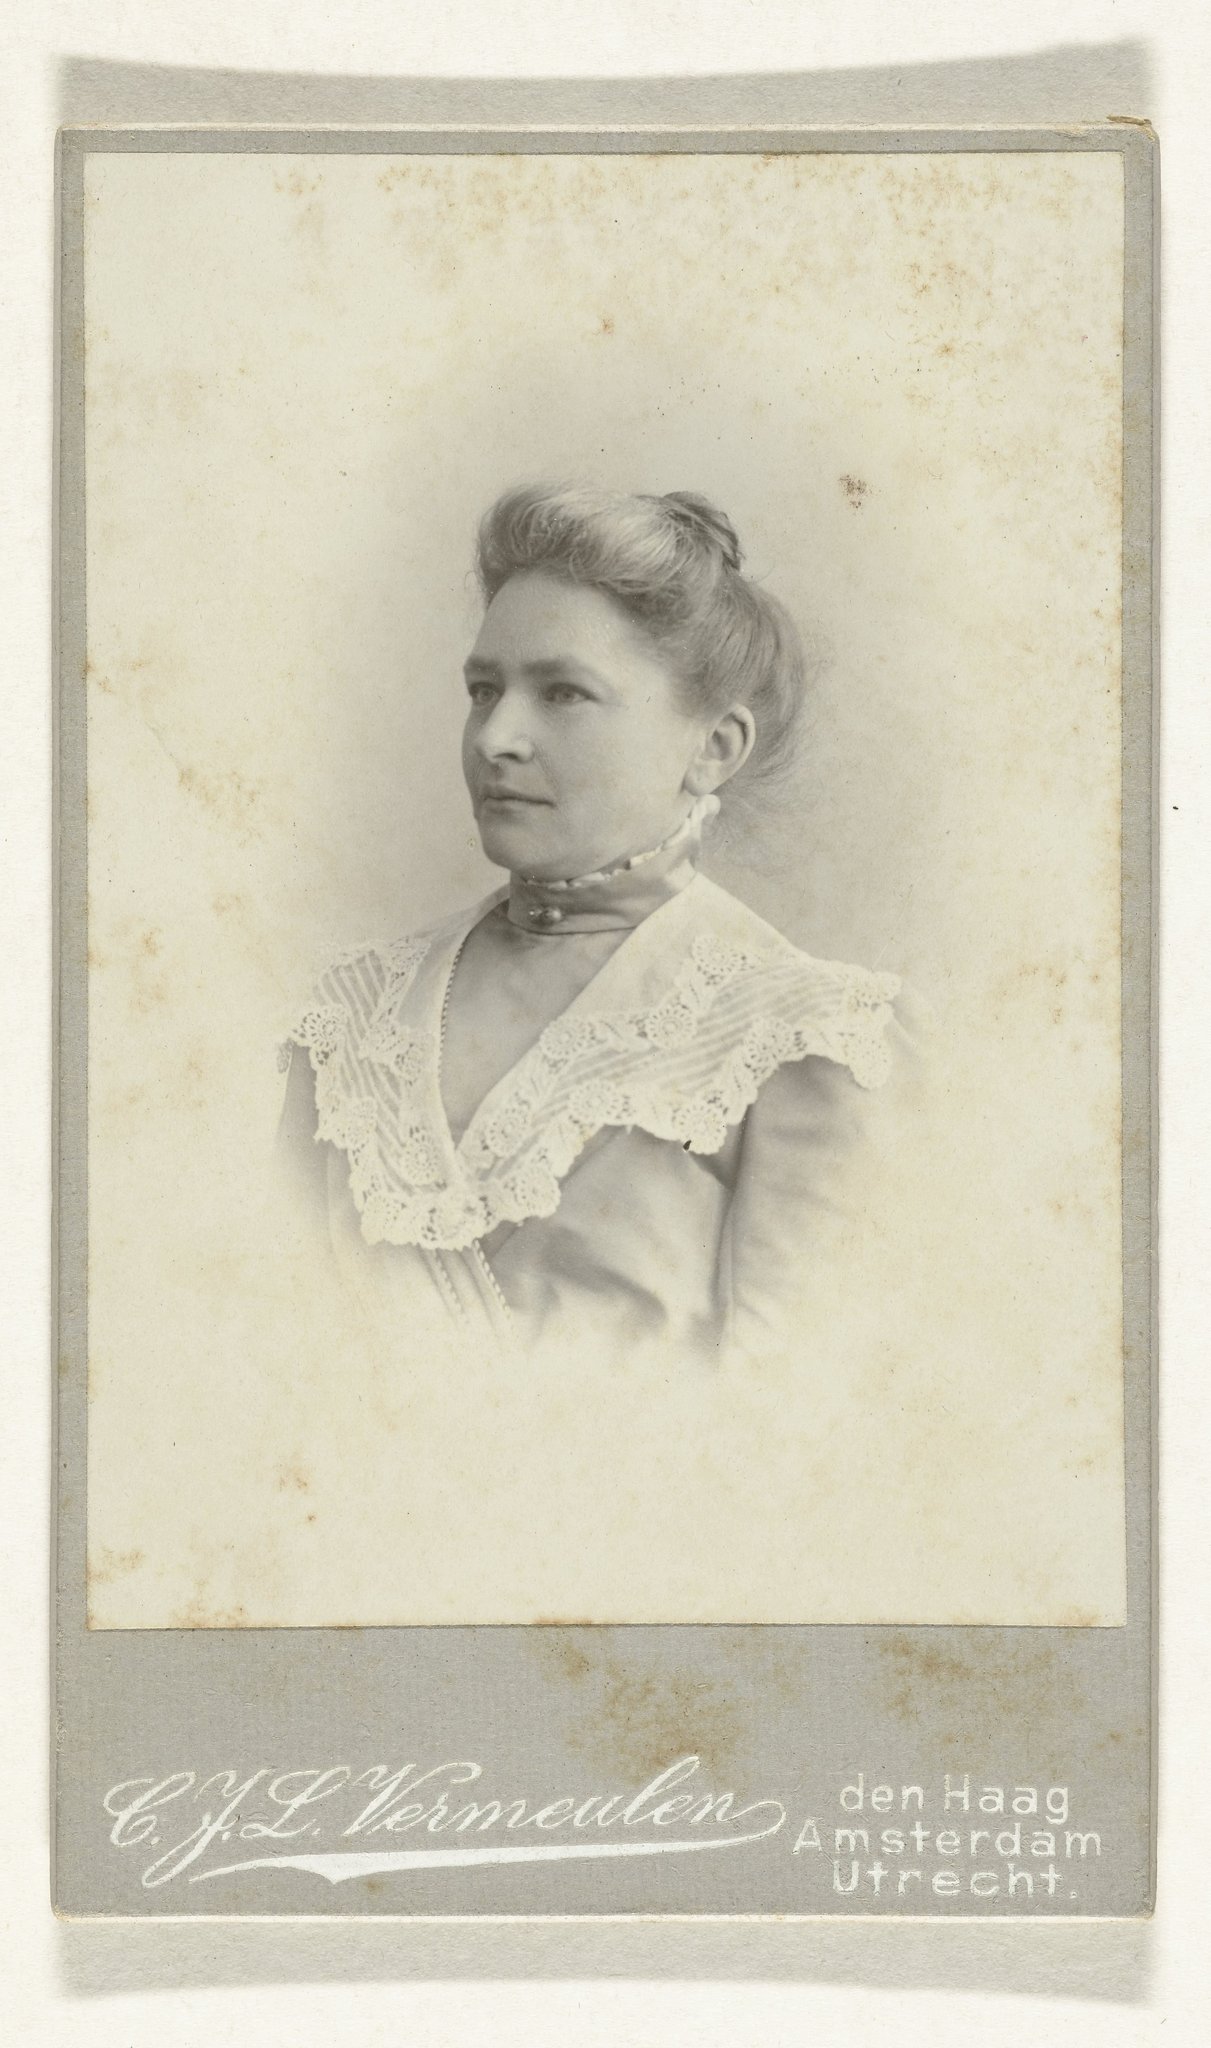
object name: photograph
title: Studioportret van een vrouw in een hooggesloten jurk, afgezet met een kantenkraag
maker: cornelis johannes lodewicus vermeulen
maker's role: fotograaf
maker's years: 1861-1936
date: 1890-1915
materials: paper, photographic support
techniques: photography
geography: the hague